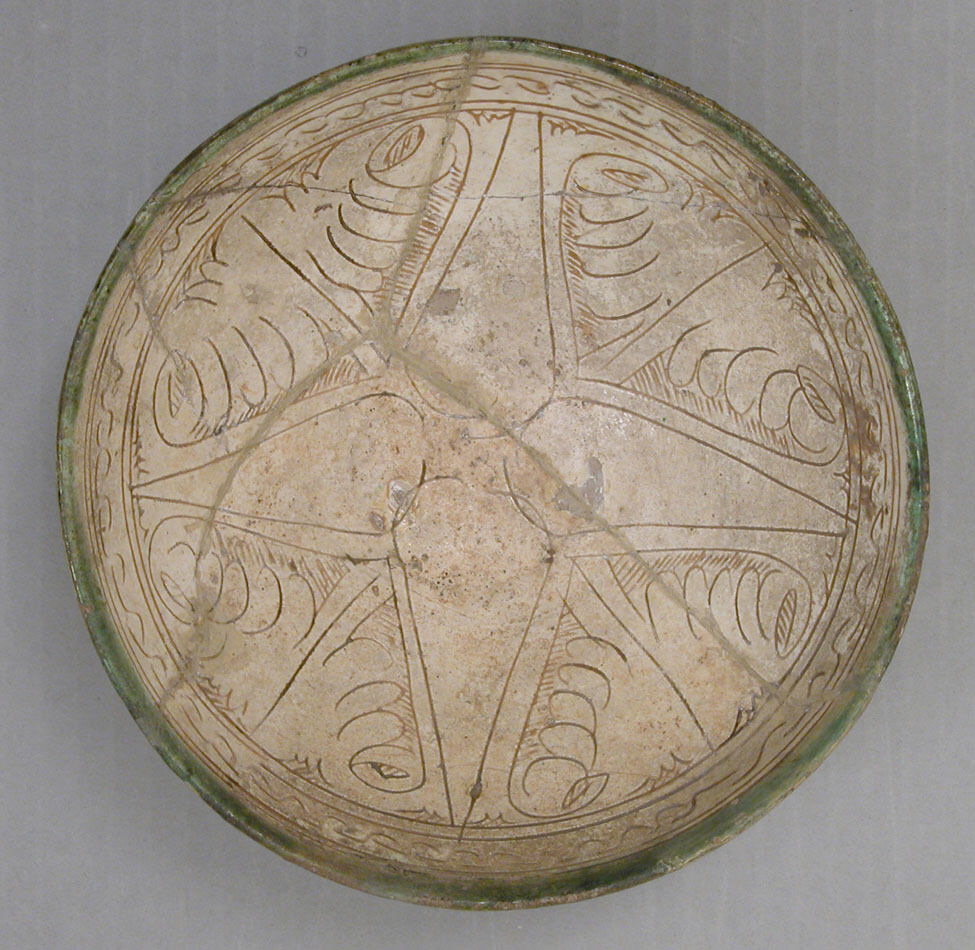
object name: bowl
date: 701-900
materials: earthenware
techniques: glazing, incising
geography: iran